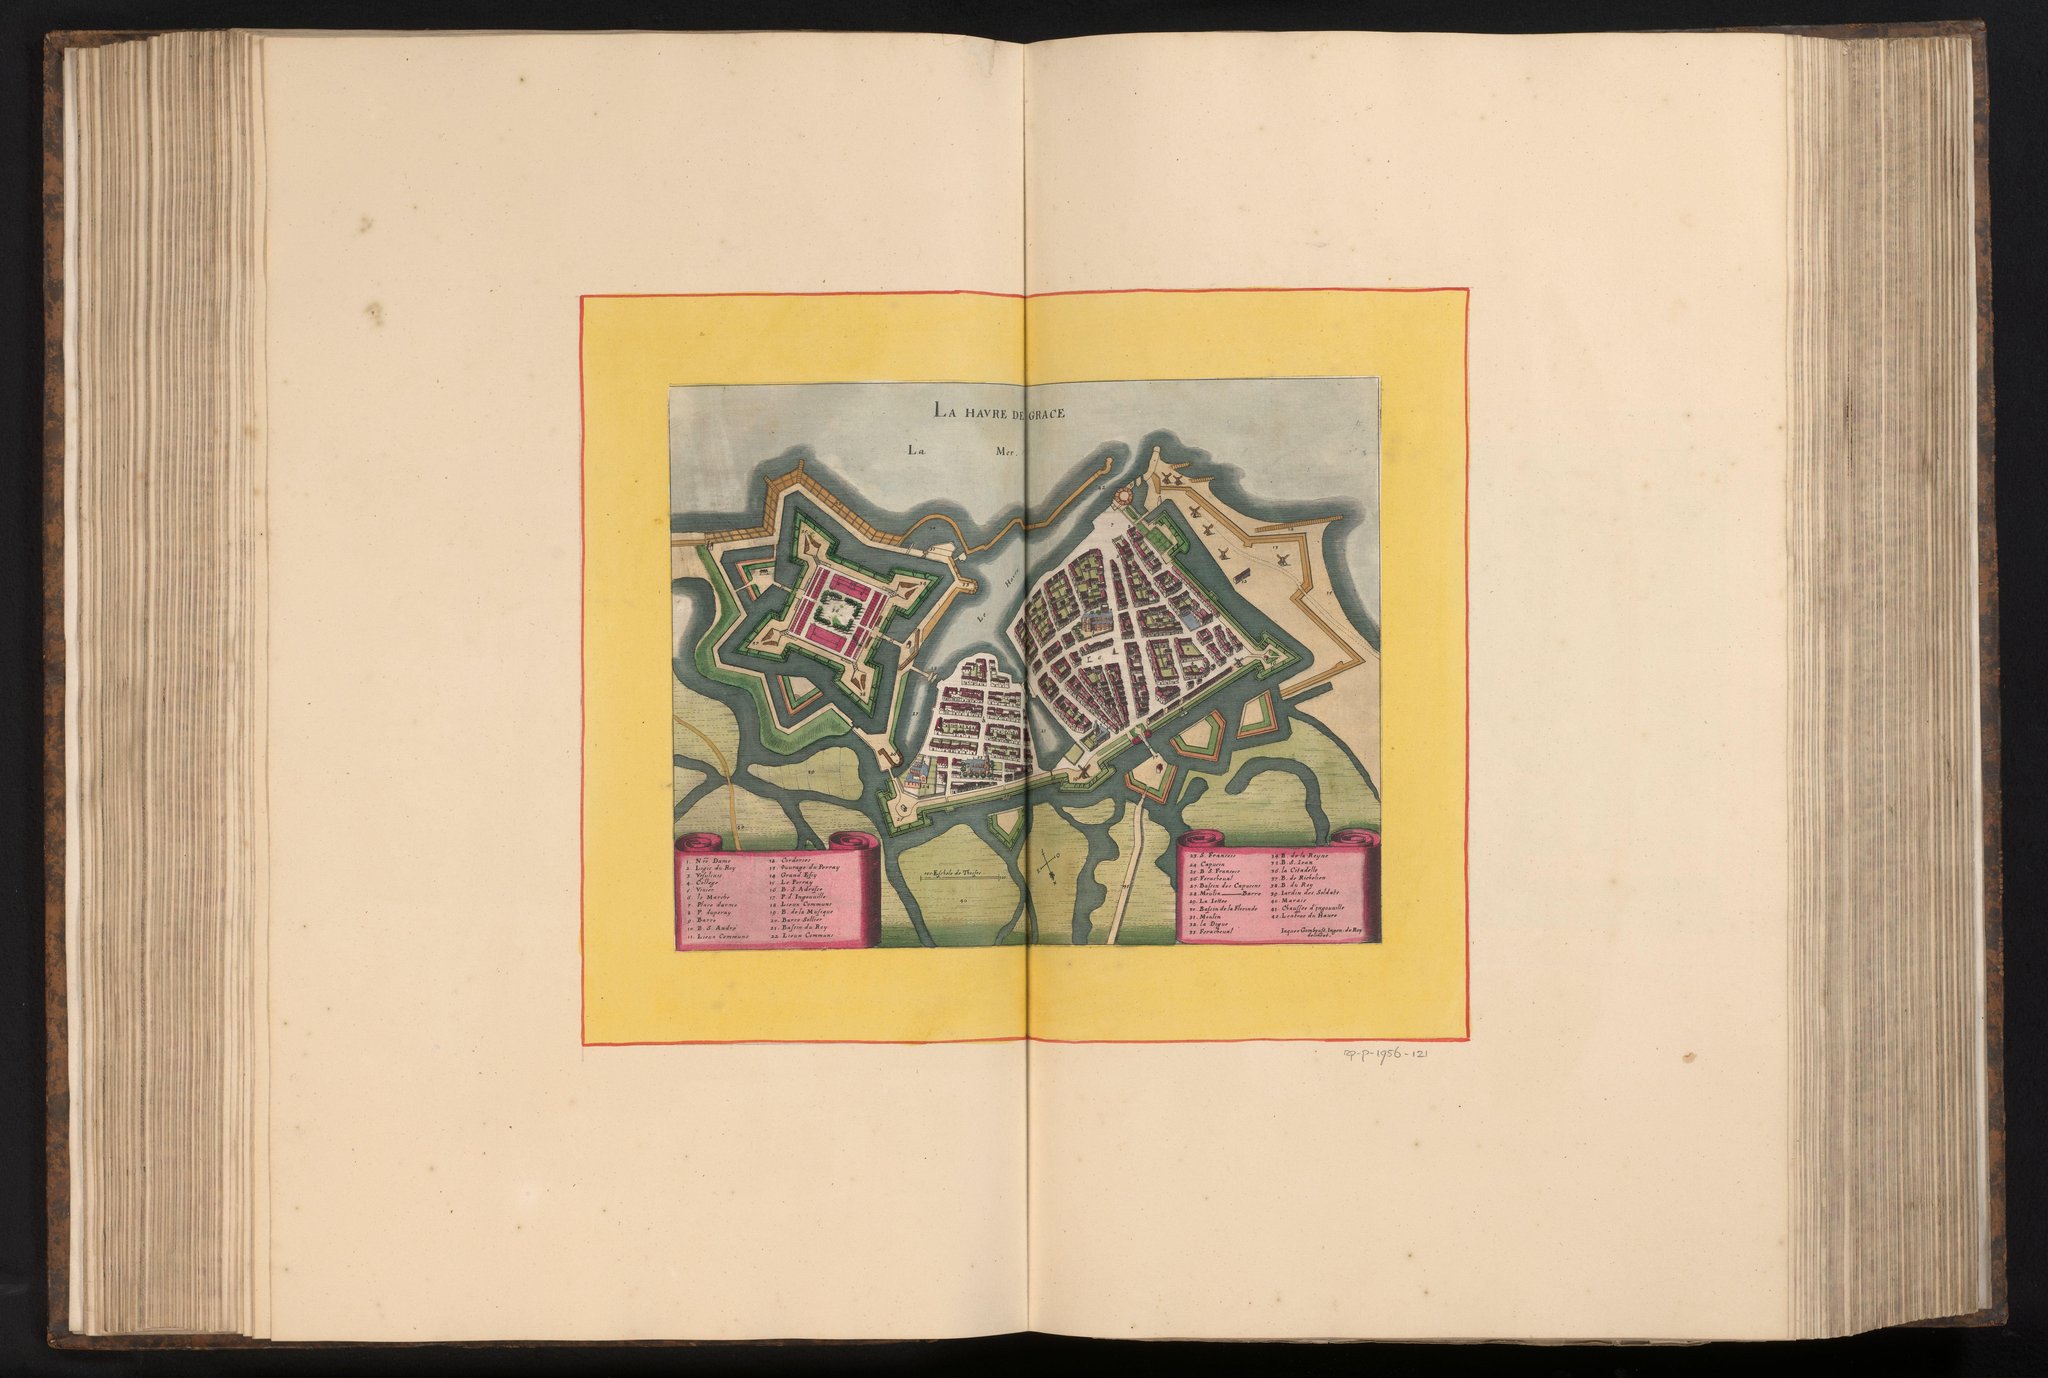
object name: area plan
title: Plattegrond van Le Havre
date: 1657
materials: paper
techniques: engraving, etching, hand coloring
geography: the hague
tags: maps of cities, le havre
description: Prent uit: Zeiller, Martin. Topographia Galliae. 13 dln. Frankfurt: Caspar Merian, 1657, dl. 8, na p. 18.